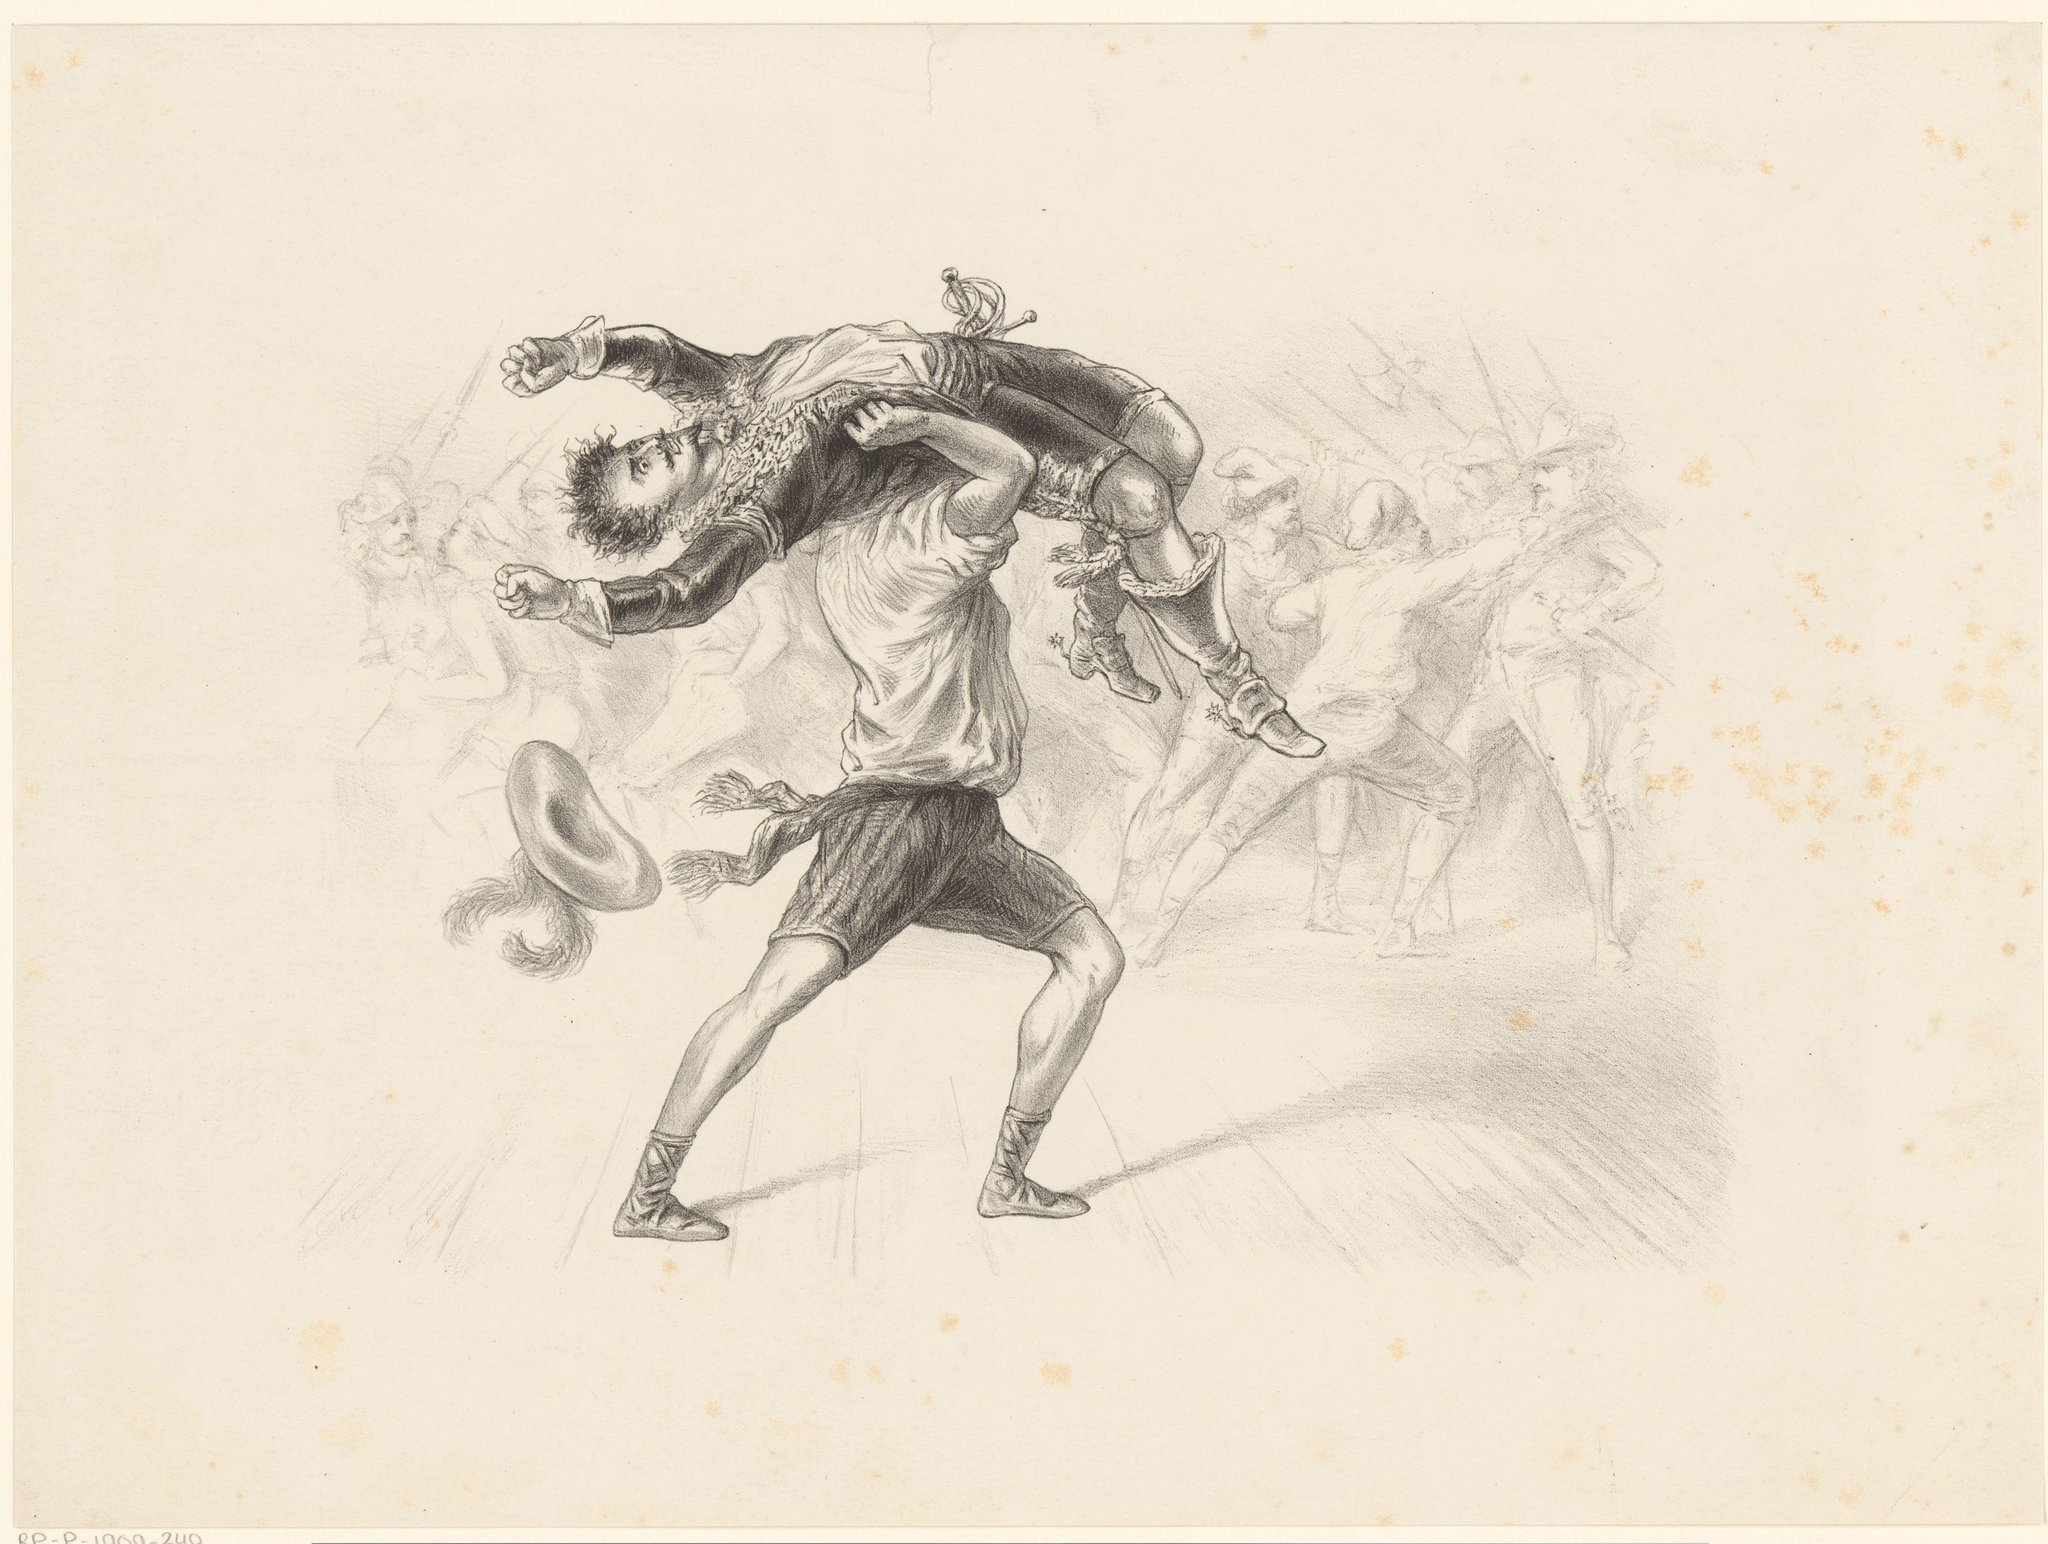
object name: print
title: Vechtende mannen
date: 1832-1897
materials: paper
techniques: lithograph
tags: being carried, fighting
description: In een gevecht tilt een man een tweede man op en gooit hem op de grond. In de achtergrond een vechtende groep mannen.